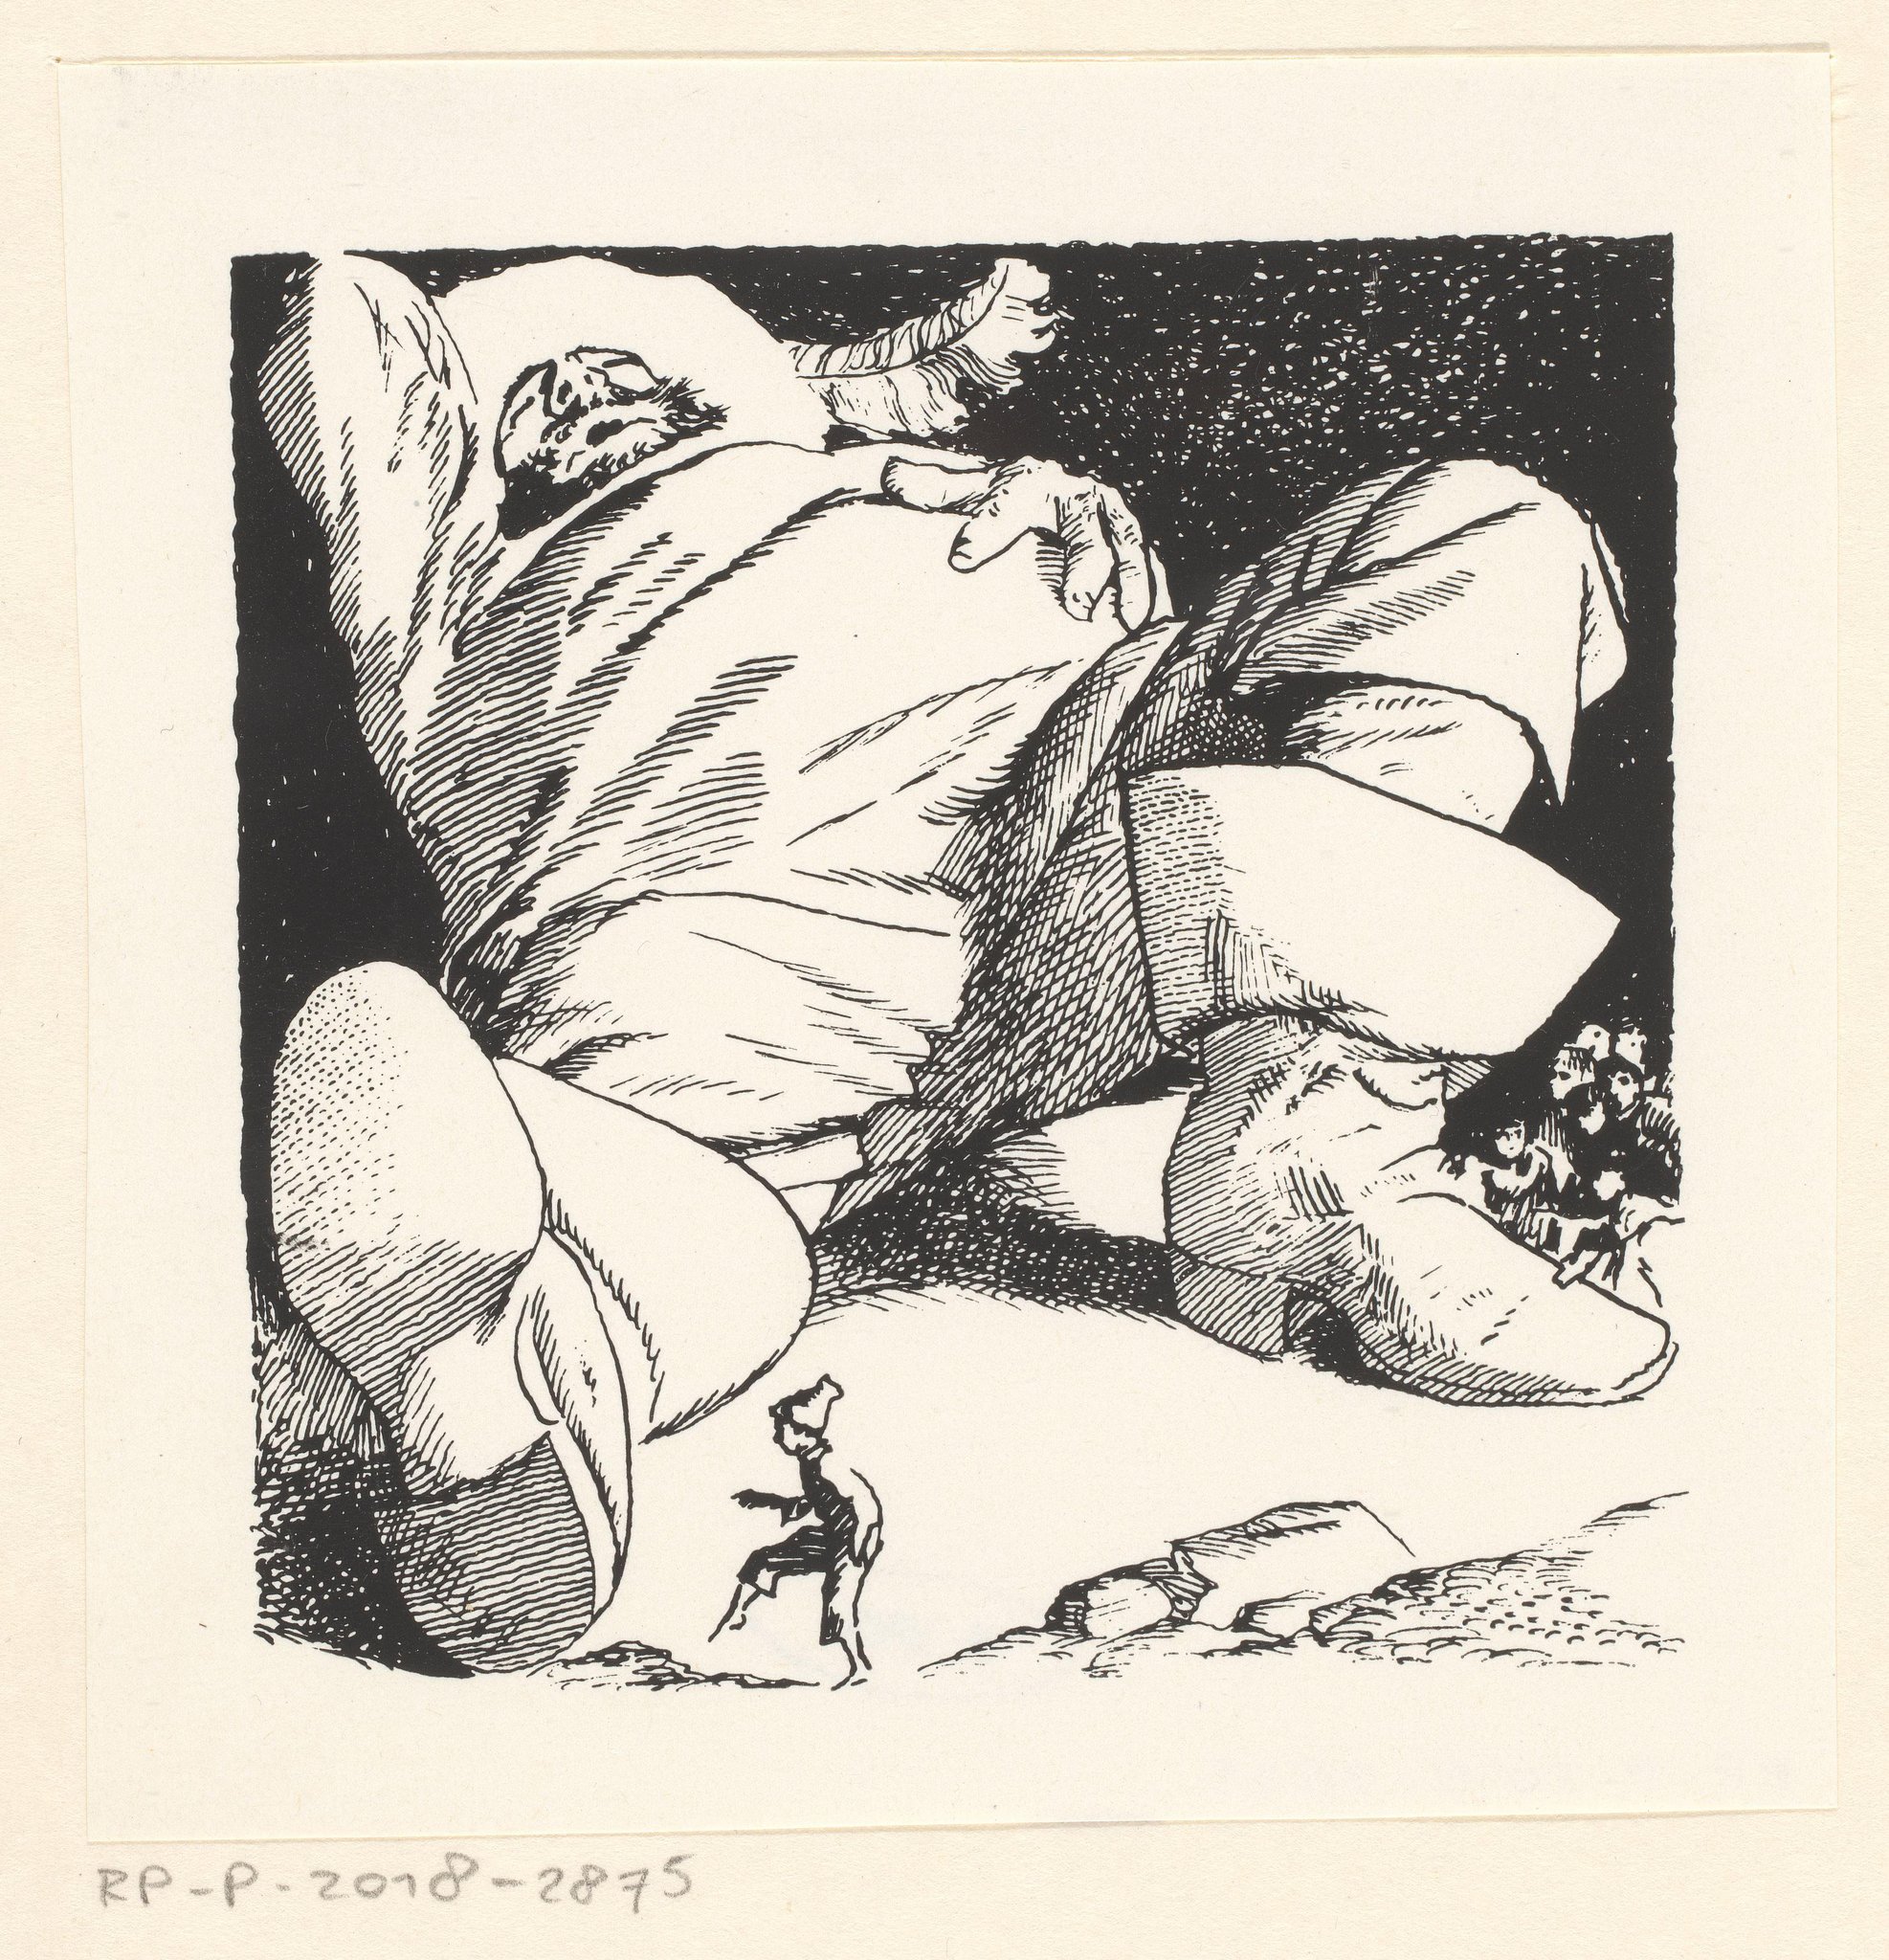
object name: photomechanical print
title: Slapende Gulliver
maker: Anonymous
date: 1895-1905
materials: paper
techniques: photochemical processes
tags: gulliver, sleeping on the ground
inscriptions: collector's mark: Lugt 2228a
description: Mogelijk een ontwerp voor Gulliver's reizen naar Lilliput door Jonathan Swift. Het boek is uitgegeven in de periode 1889-1904 bij Uitgeversmaatschappij L.J. Veen te Amsterdam.